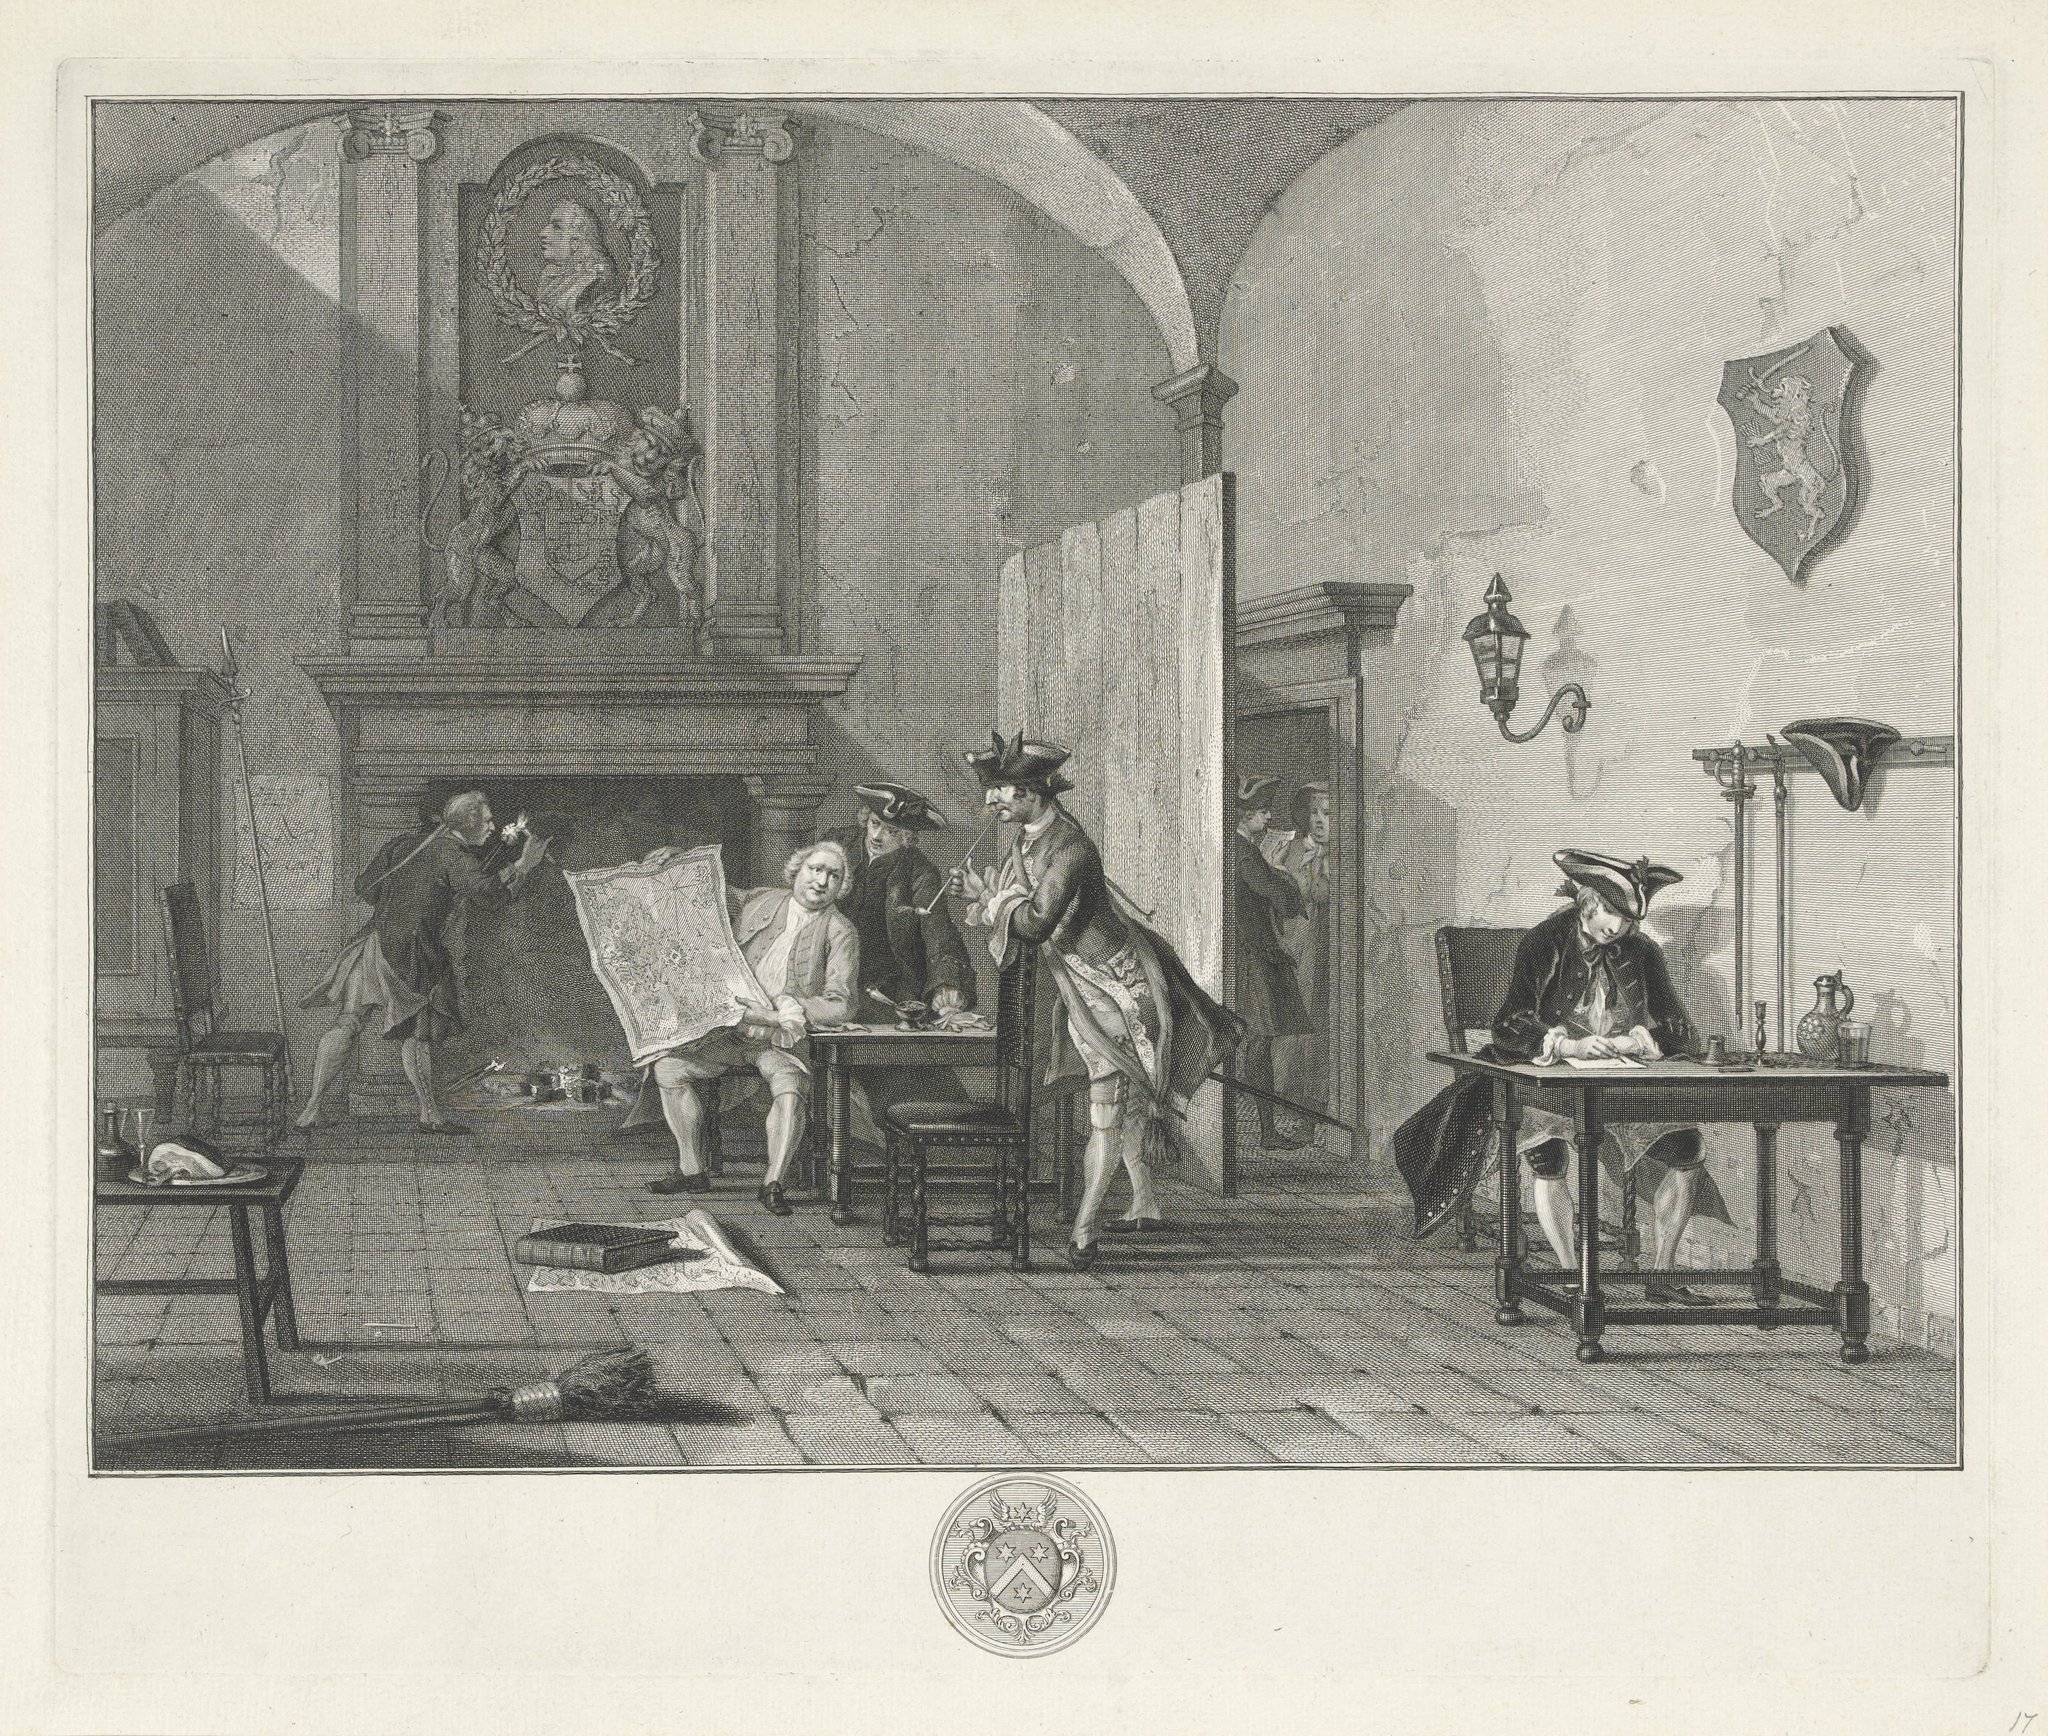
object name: print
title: Tweede corps de garde van Hollandsche officiers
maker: jacob houbraken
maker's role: draughtsman, print maker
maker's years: 1698-1780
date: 1758-1760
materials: paper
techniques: engraving, etching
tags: open hearth, fire-place, handwriting, written text, studying a map, meeting of soldiers and/or officers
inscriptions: collector's mark: Lugt 240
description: Een interieur met verschillende officieren. Rechts zit een man aan een schrijftafel, links is een man bezig met vuur uit de open haard, in het midden kijken drie heren op een kaart. Boven de schoorsteen een wapenschild en daarboven een met een lauwerkrans omgeven portret van een man en profil.